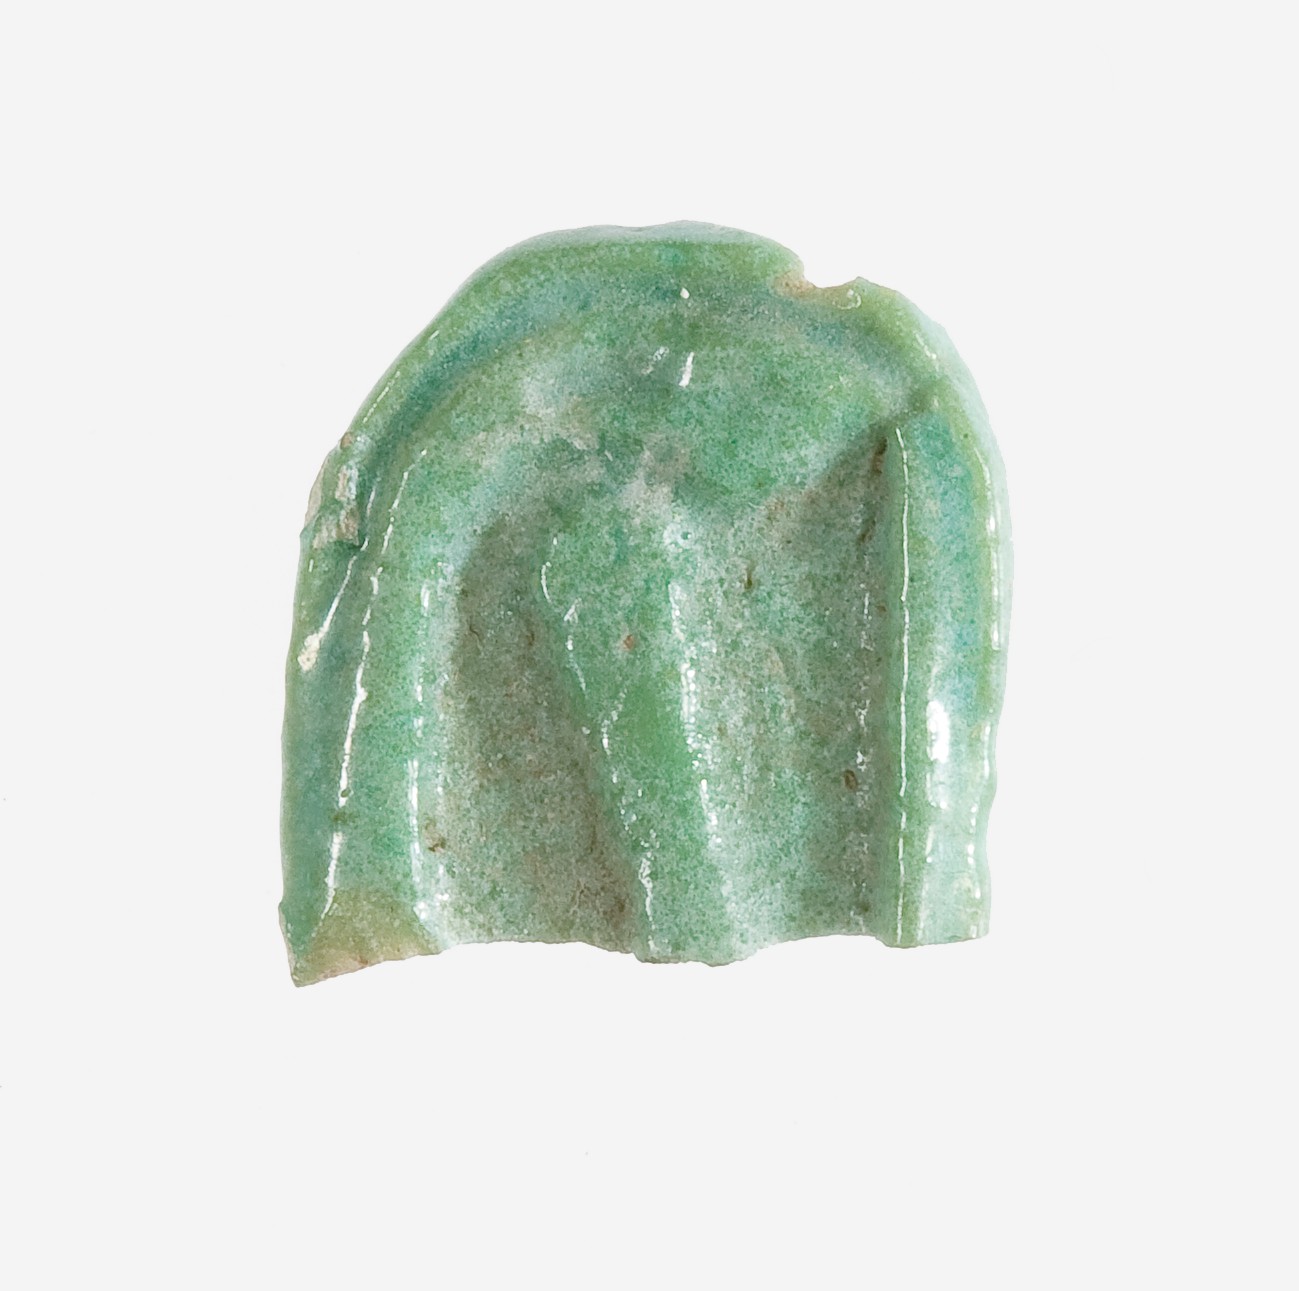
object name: ring fragment, maat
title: Ring Fragment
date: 1390-1352 BCE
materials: faience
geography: egypt